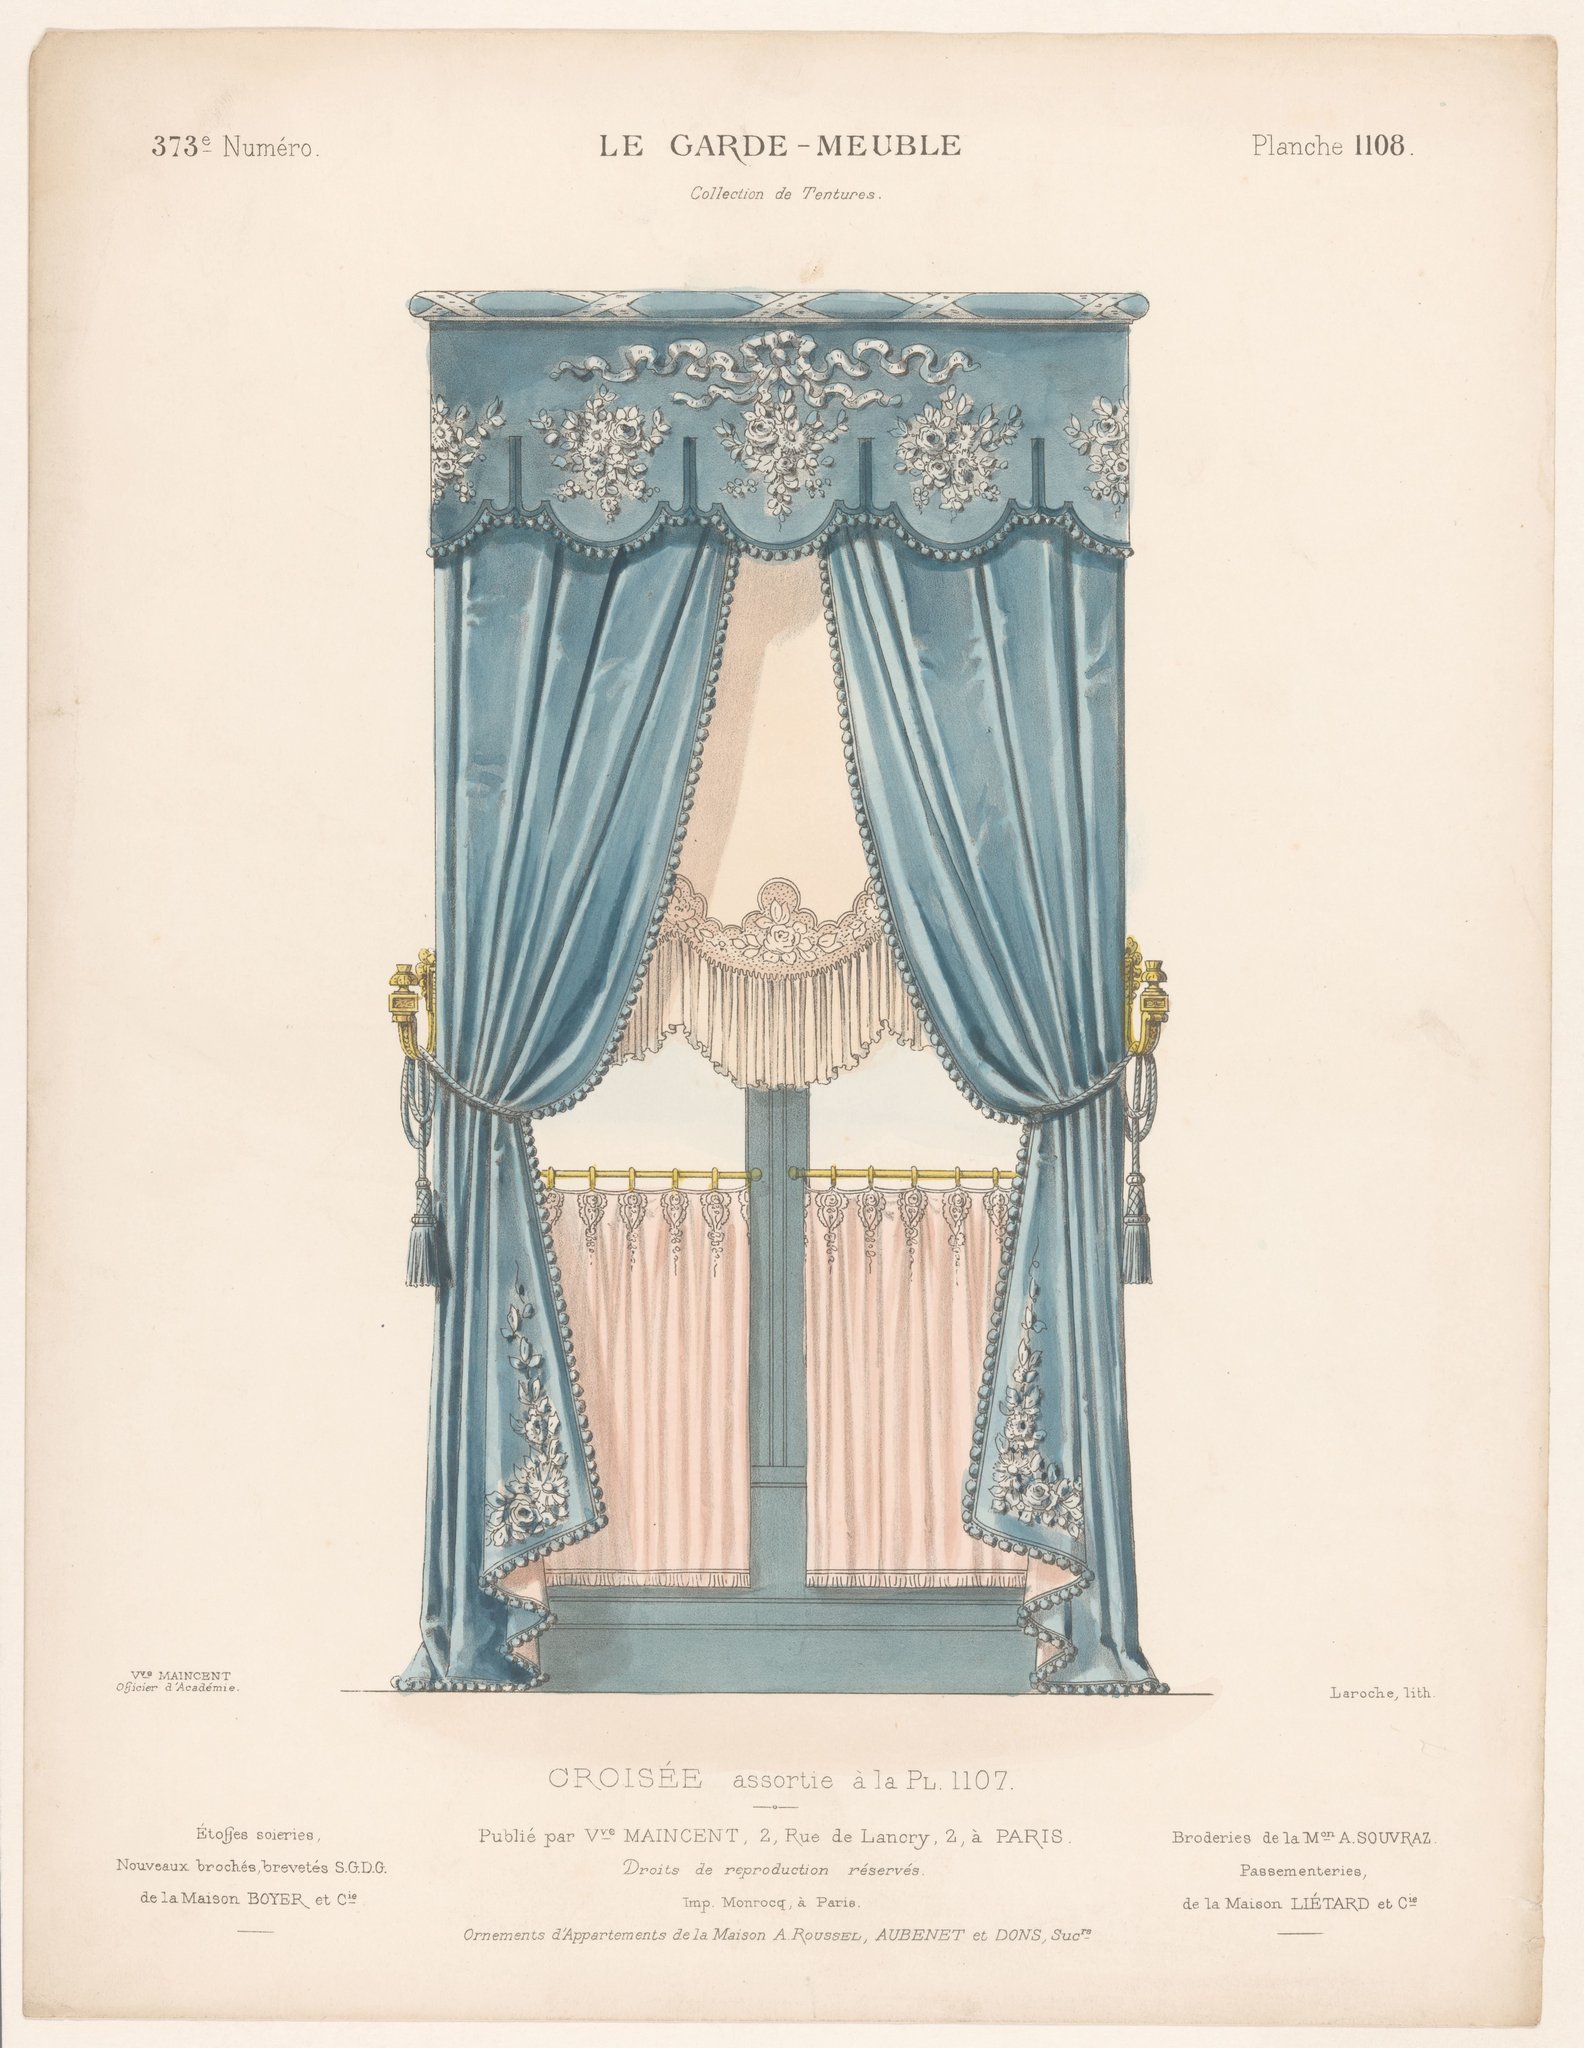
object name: print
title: Croisée assortie à la Pl. 1107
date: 1895-1910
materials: paper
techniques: hand coloring, lithograph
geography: paris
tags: window, hangings and drapery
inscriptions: : ‘Droits de reproduction réservés.’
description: Kruisvenster met gedrapeerde gordijnen, passend bij serienr. 1107. Prent uit 373e Livraison.